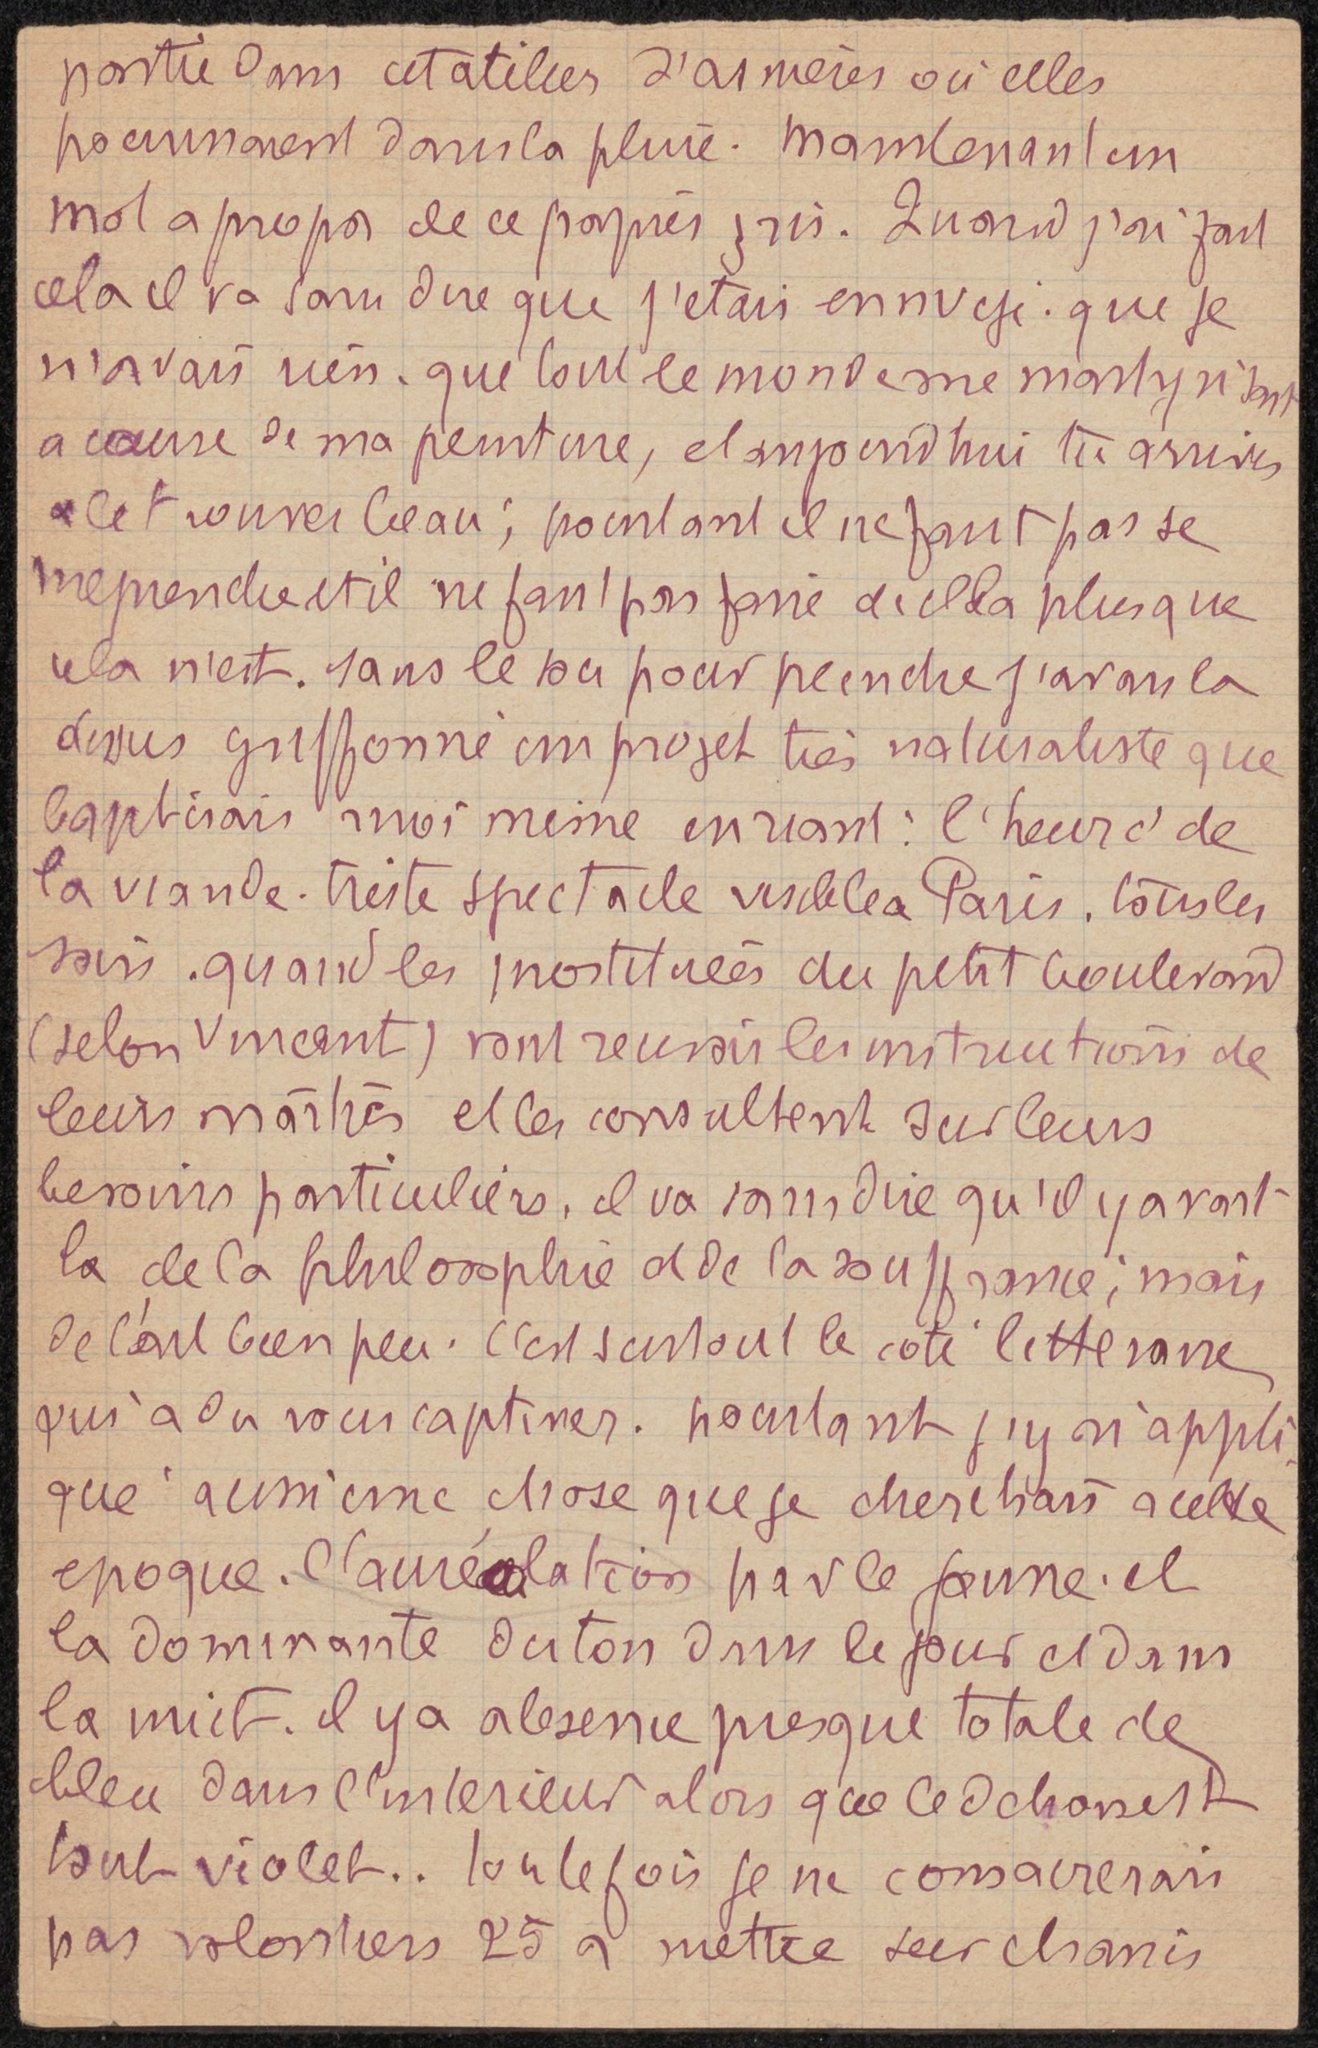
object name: letter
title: Brief aan Héloïse Bernard-Bodin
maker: émile bernard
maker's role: print maker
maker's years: 1868-1941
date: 1894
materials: ink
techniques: pen, writing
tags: héloïse bernard-bodin